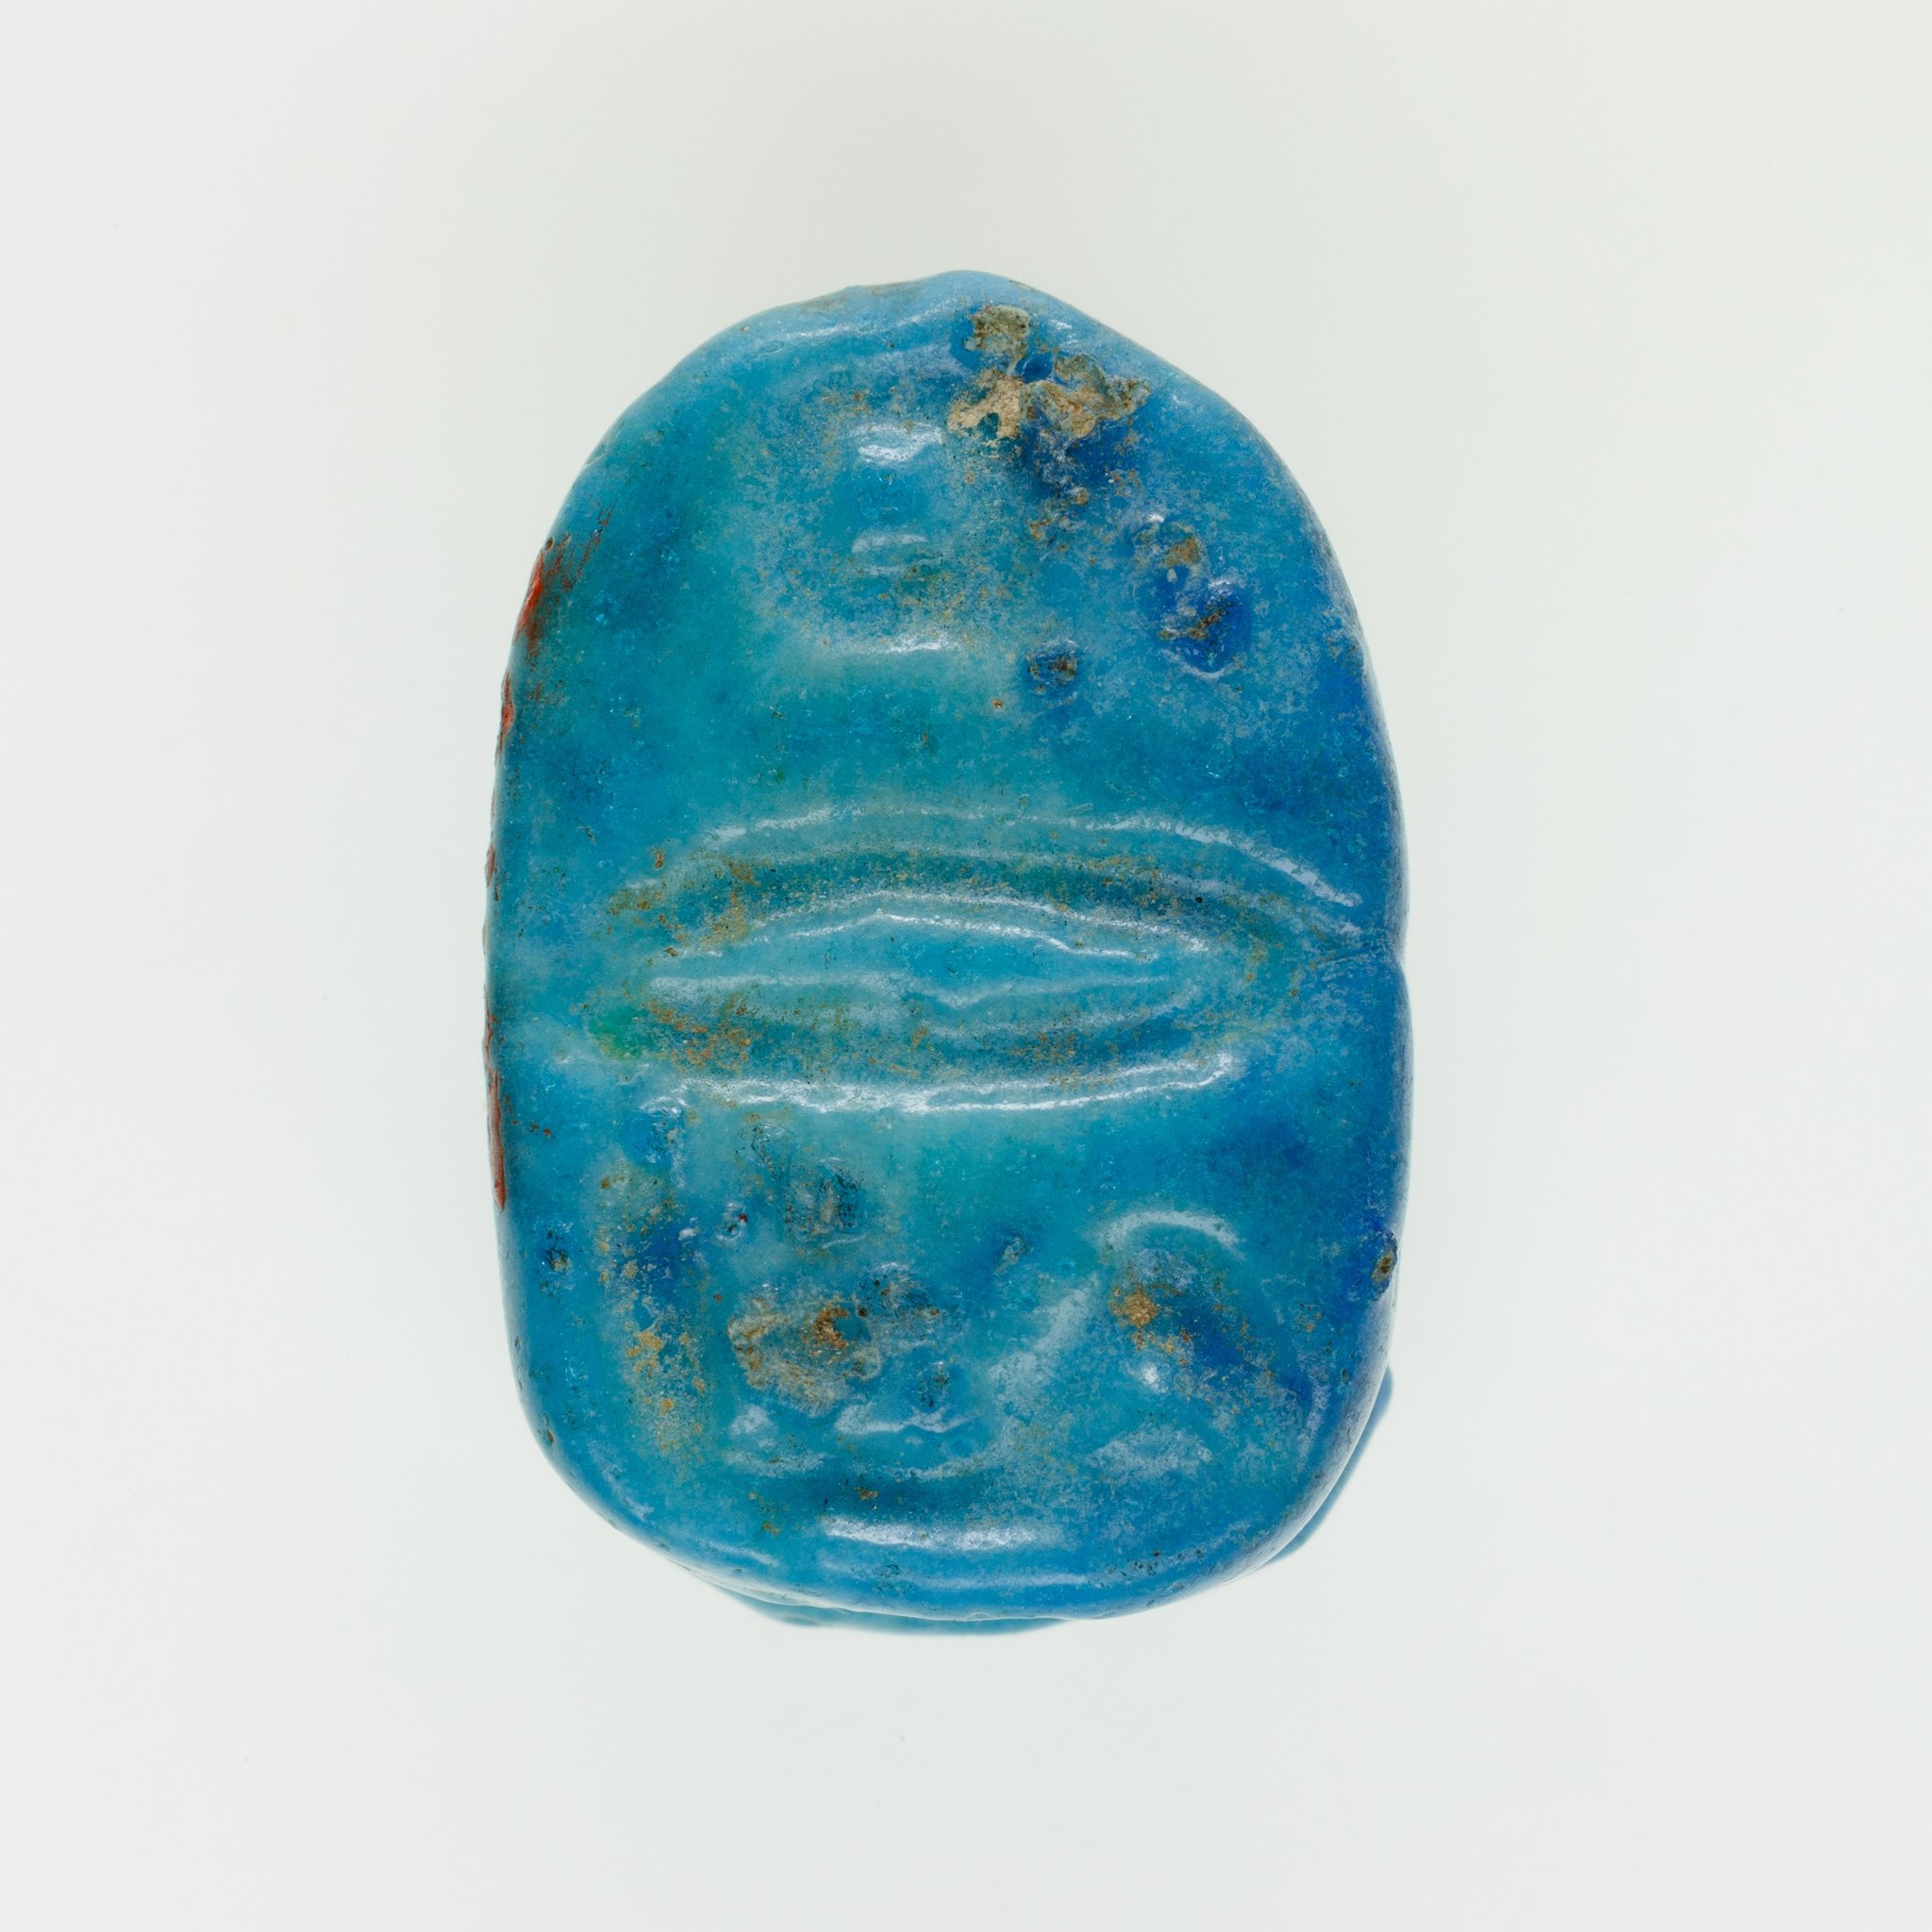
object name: scarab, hieroglyph, rdi ra, re give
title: Scarab Inscribed with a Blessing Related to Re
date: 1640-1550 BCE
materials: faience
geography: egypt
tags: scarabs